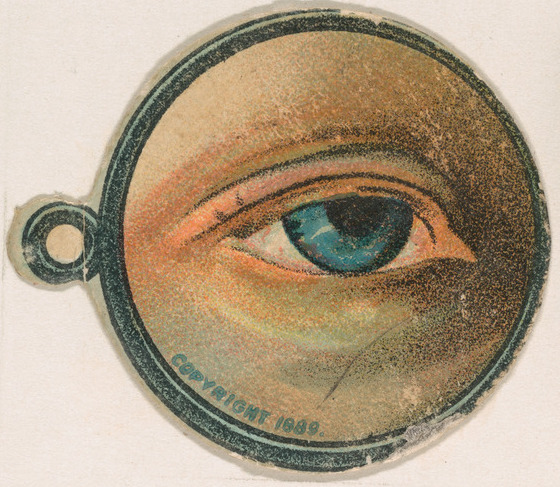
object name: print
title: Monocle and Eye (blue), from Jocular Ocular series (N221) issued by Kinney Bros.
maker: kinney brothers tobacco company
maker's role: publisher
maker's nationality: american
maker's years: 1869-2011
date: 1889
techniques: color lithograph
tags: eyes